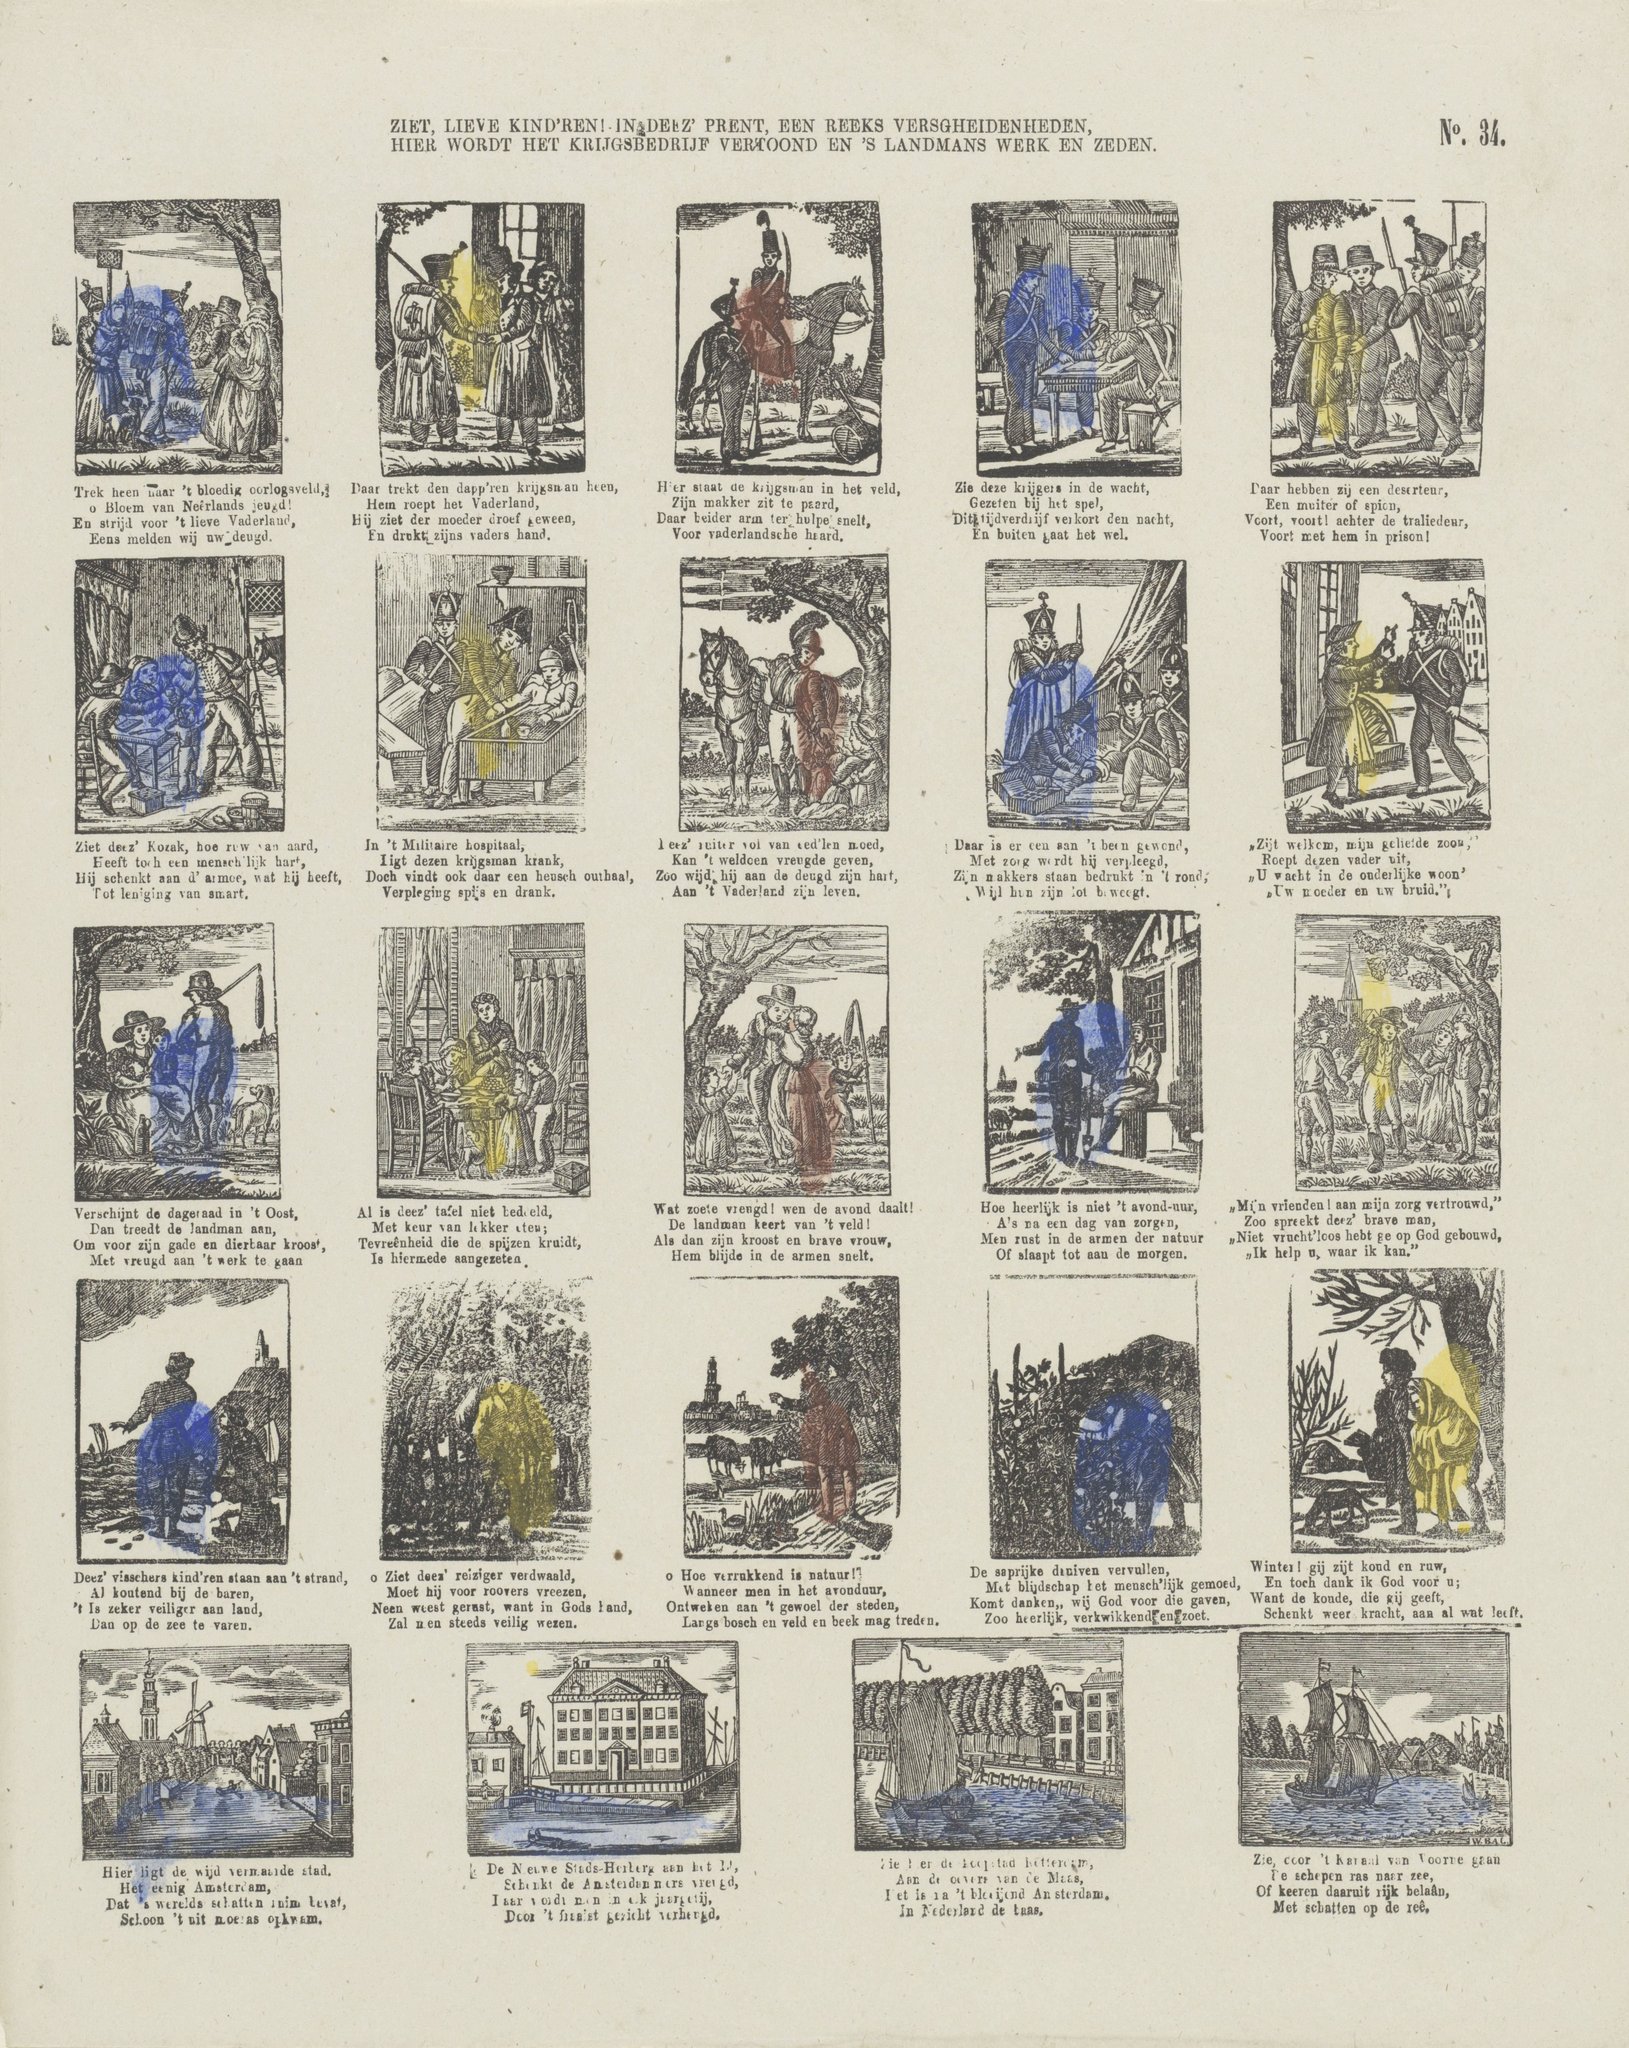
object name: print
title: Ziet, lieve kind'ren! in deez' prent, een reeks versgeidenheden, / Hier wordt het krijgsbedrijf vertoond en 's landmans werk en zeden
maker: willem bal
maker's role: print maker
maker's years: 1808-1897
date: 1850-1870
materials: paper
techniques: colour, letterpress printing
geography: netherlands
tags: farmers, ships (in general), the soldier; the soldier's life, rural life, amsterdam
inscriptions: collector's mark: Lugt 2760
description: Blad met 24 voorstellingen van verschillende aard, zoals voorstellingen van militairen en van het boeren leven. Onder elke afbeelding een vierregelig vers. Rechtsboven genummerd: No. 34.